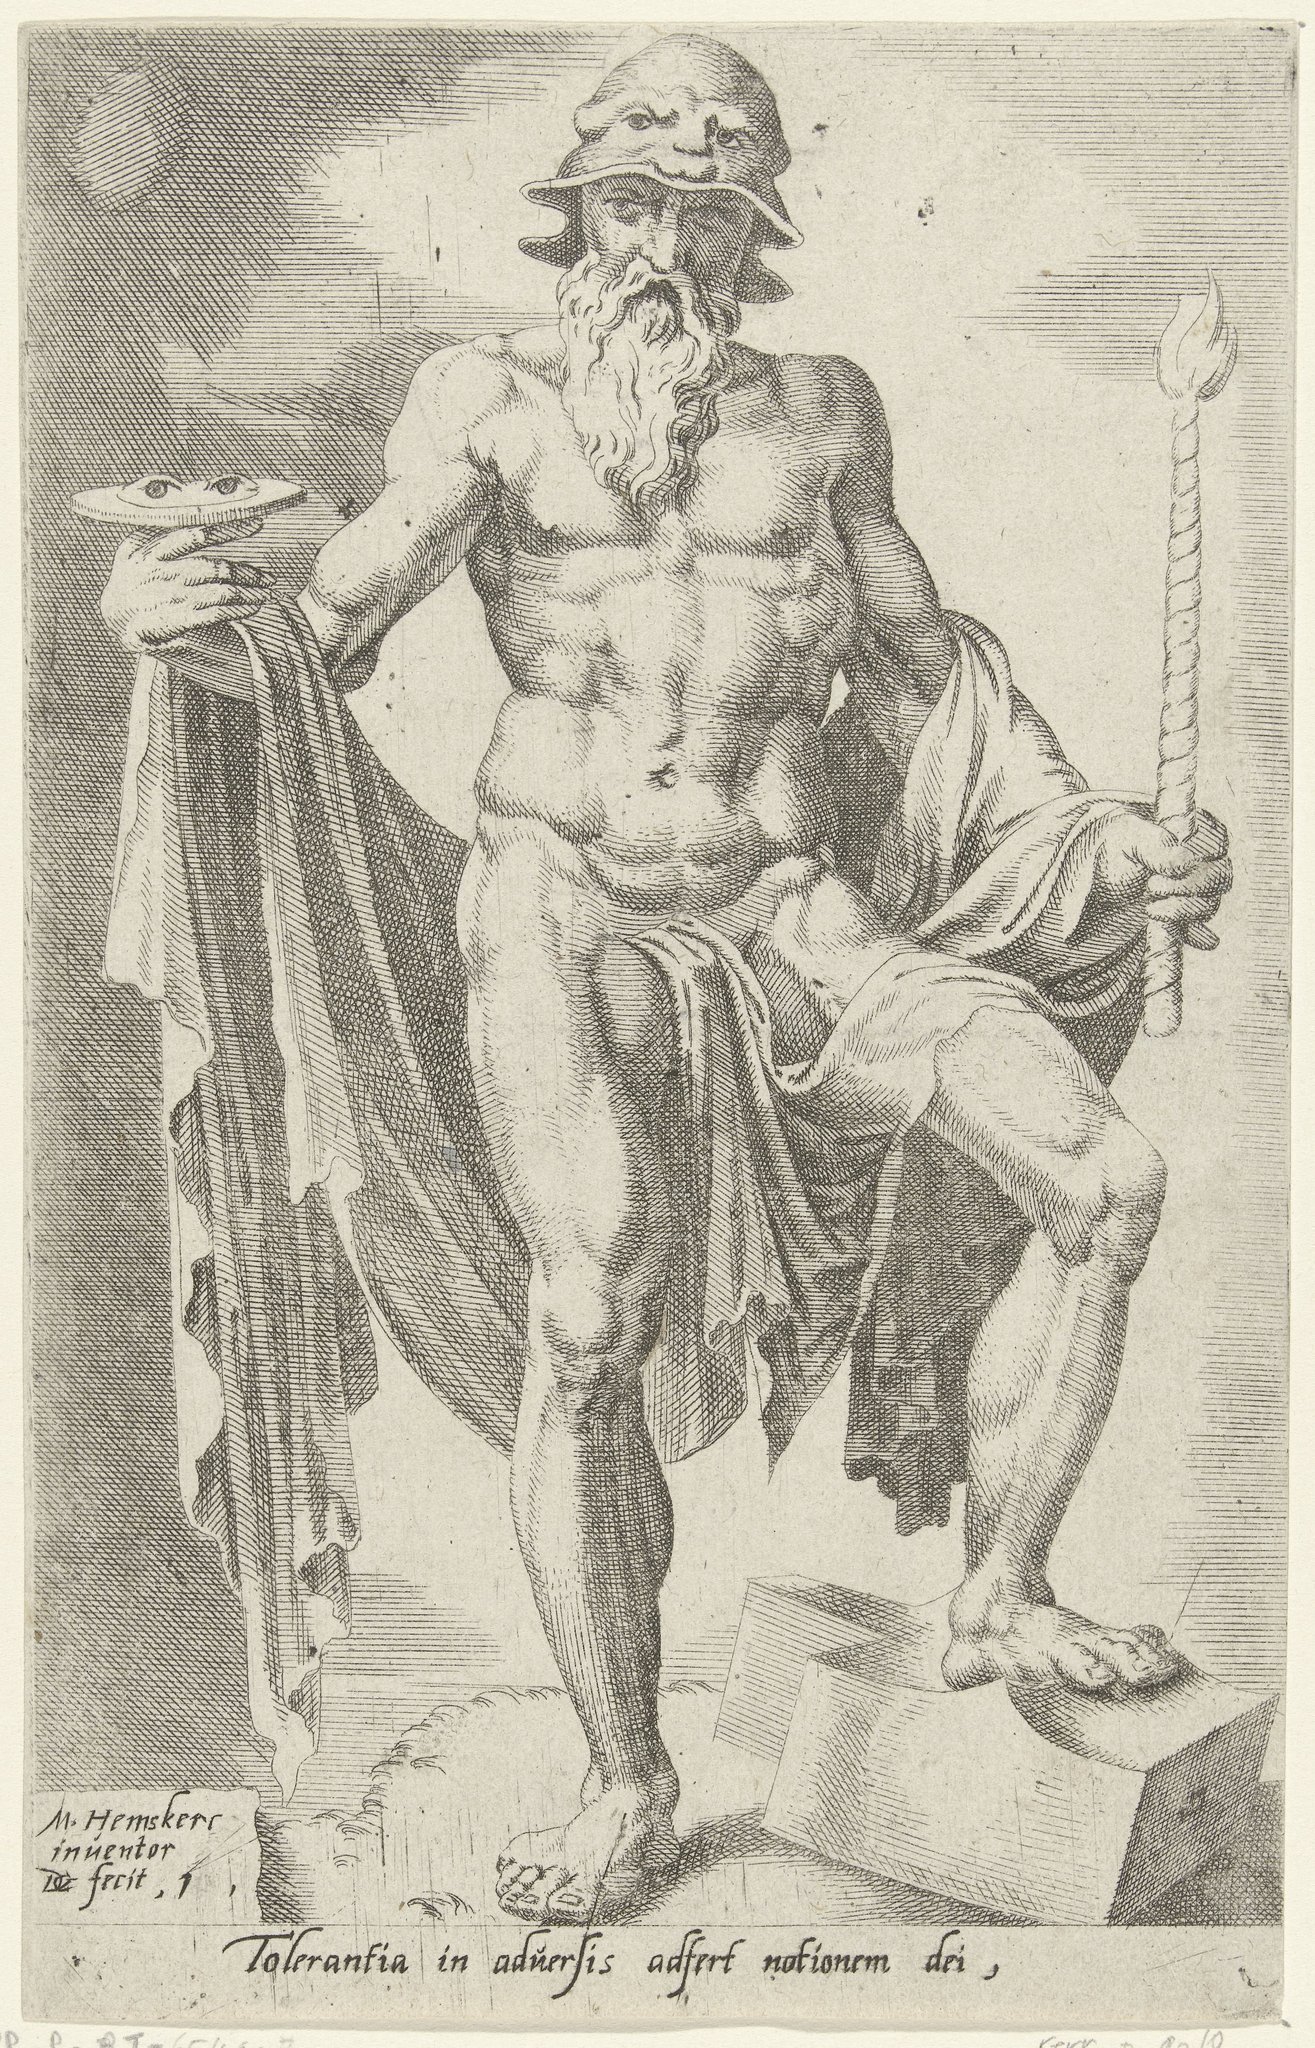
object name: print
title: Jakobs ladder of de allegorie van de weg naar eeuwige zaligheid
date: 1550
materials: paper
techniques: etching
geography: haarlem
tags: torch, the all-seeing eye, triangle with eye ~ symbol of god the father, eternal bliss; 'felicità eterna' (ripa) (+ symbolical representation of concept), tools, aids, implements ~ crafts and industries: anvil, tolerance, long-suffering; 'longanimità', 'toleranza' (ripa)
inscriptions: collector's mark: Lugt 2228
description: De personificatie van Tolerantie. Hij staat met een been op een aambeeld, het attribuut van Geduld. In zijn linkerhand de fakkel van kennis en in zijn rechterhand een schaal met twee ogen. Deze staan symbool voor God. De prent heeft een Latijns onderschrift en maakt deel uit van een veertiendelige serie met als onderwerp de manier om eeuwige zaligheid te bereiken.